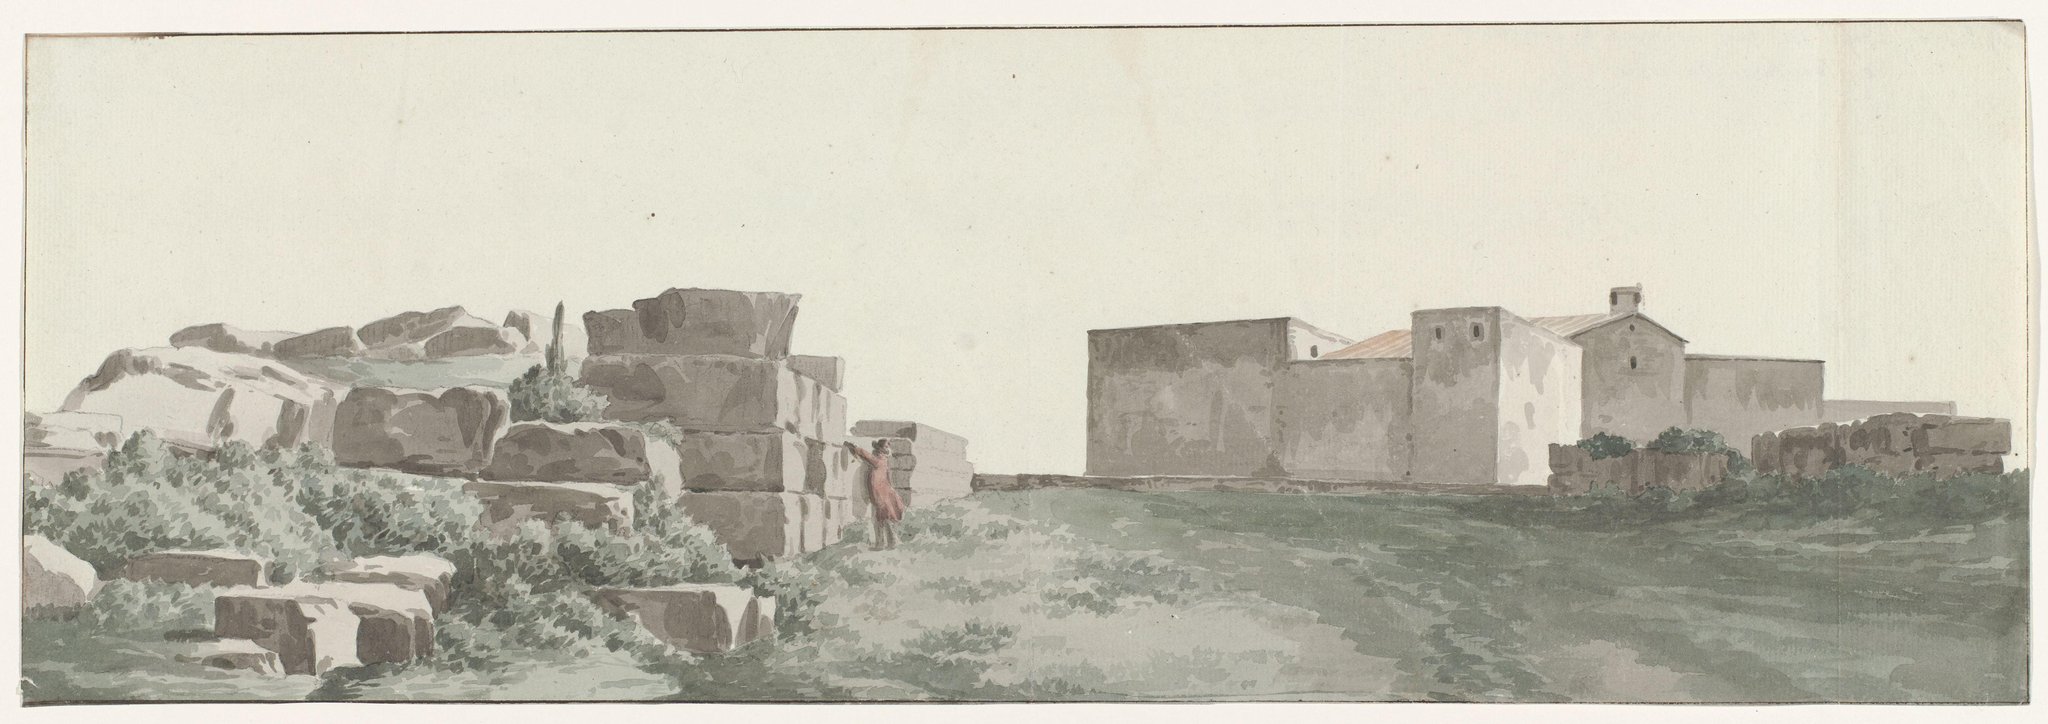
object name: drawing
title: Profiel van de binnenmuren en buitenmuren van de oude stad Manduria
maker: louis ducros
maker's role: draughtsman, print maker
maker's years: 1748-1810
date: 1778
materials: chalk, paper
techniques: brush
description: Tekening uit het album 'Voyage en Italie, en Sicile et à Malte', 1778.